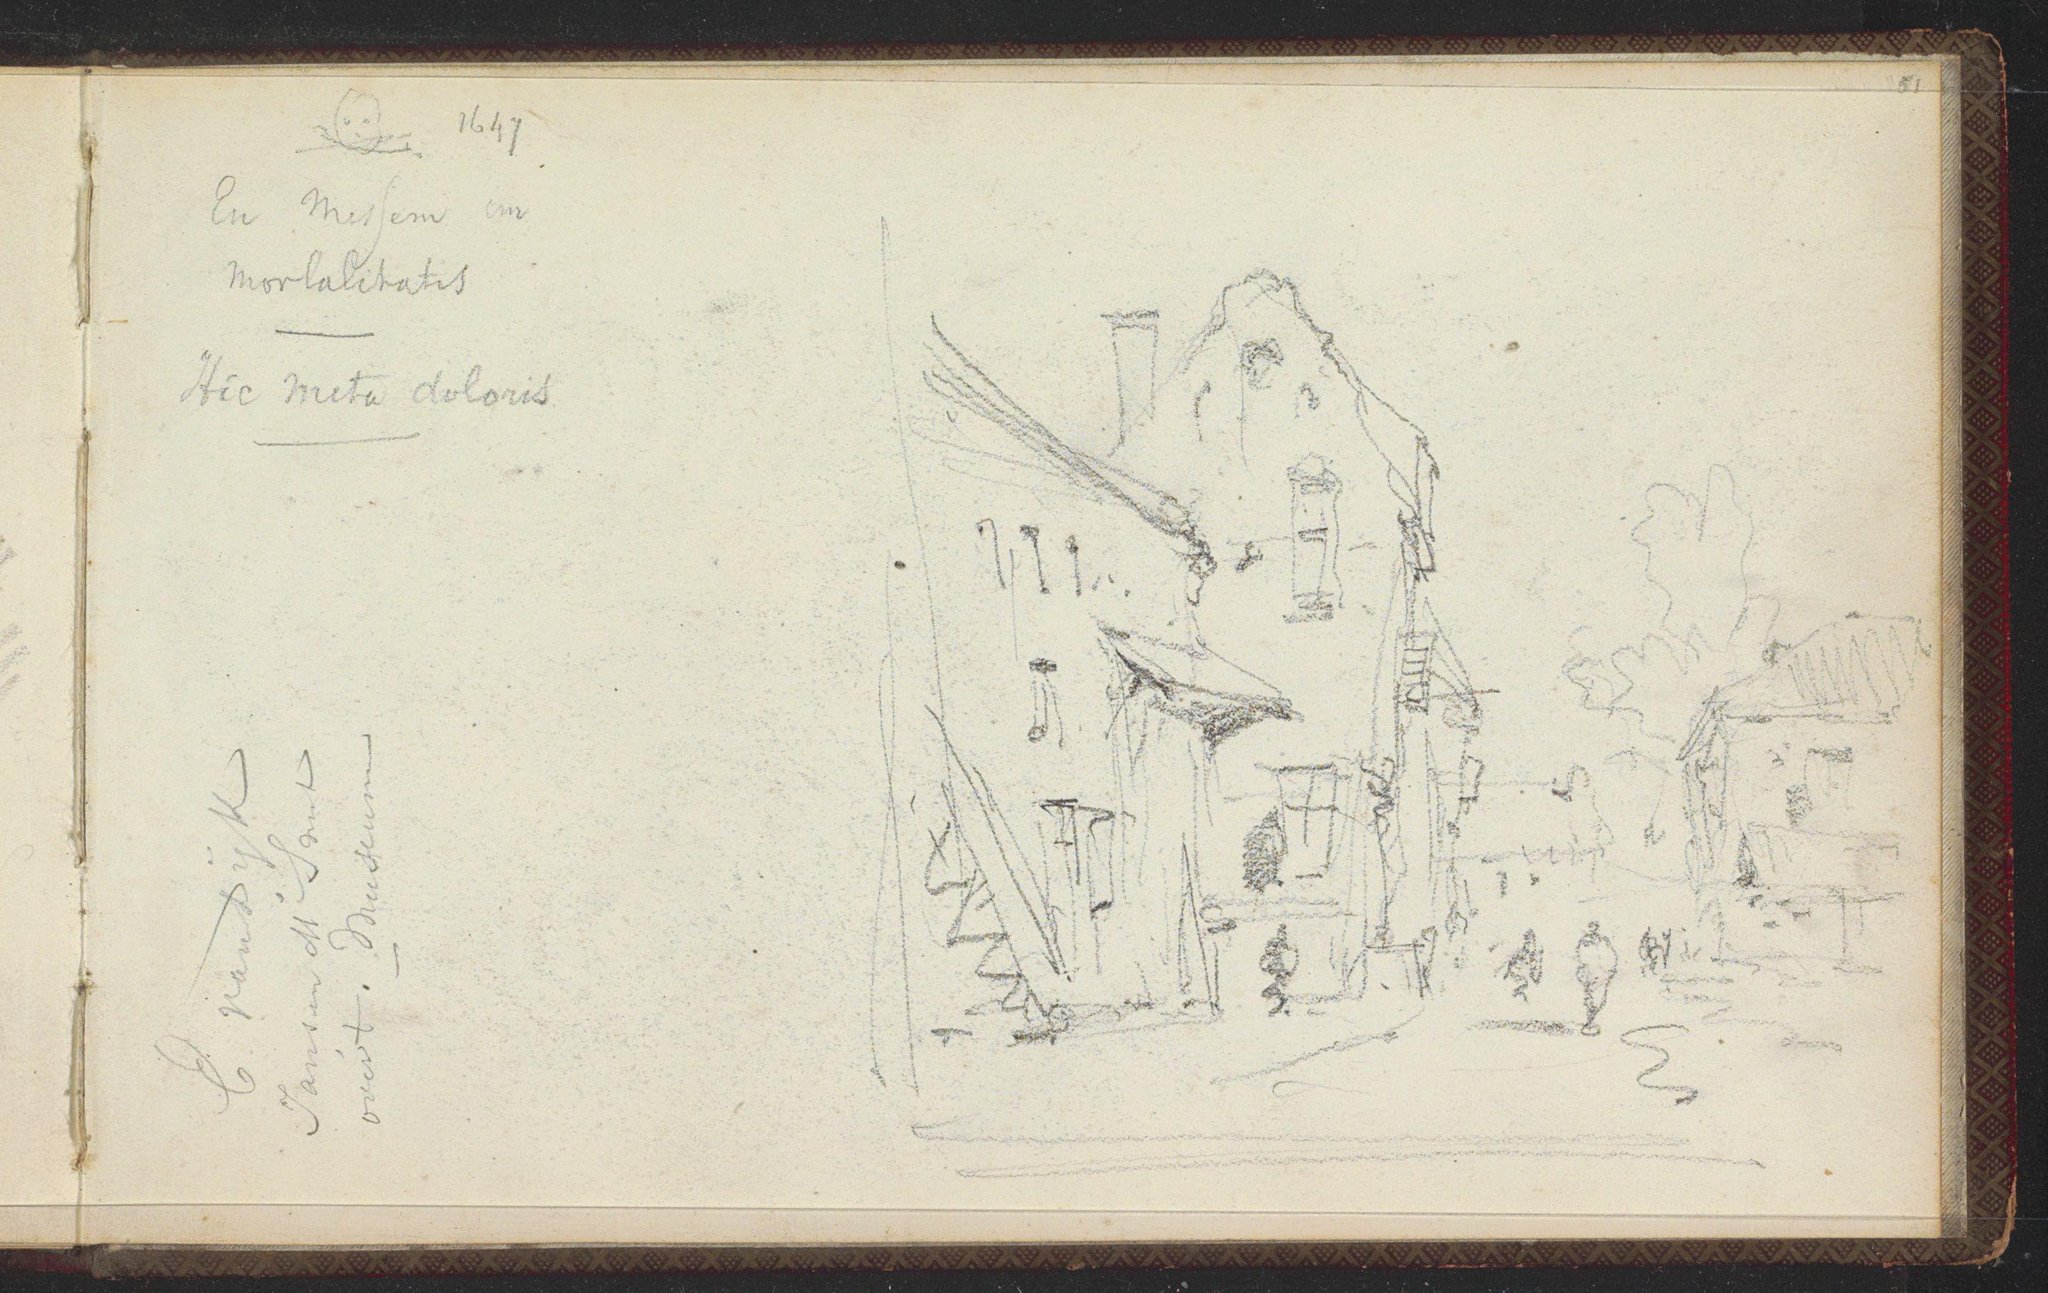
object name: endleaf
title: Gezicht op een straat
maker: adrianus eversen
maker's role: draughtsman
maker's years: 1818-1897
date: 1828-1897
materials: paper, pencil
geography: netherlands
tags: architecture, civic architecture; edifices; dwellings, street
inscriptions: annotation: ‘1647/ In messem im/ mortalitatis/ Hic meta doloris’, name: ‘E. van Dijk/ Jansen M'Sant/ [...] Museum’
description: Rechts een gezicht op een straat met figuren. Links en rechts staan gebouwen. In de verte een boom. Blad 51 uit een schetsboek met 52 bladen vervaardigd in de omgeving van Kampen, Hattem, Hoorn en Zwolle.